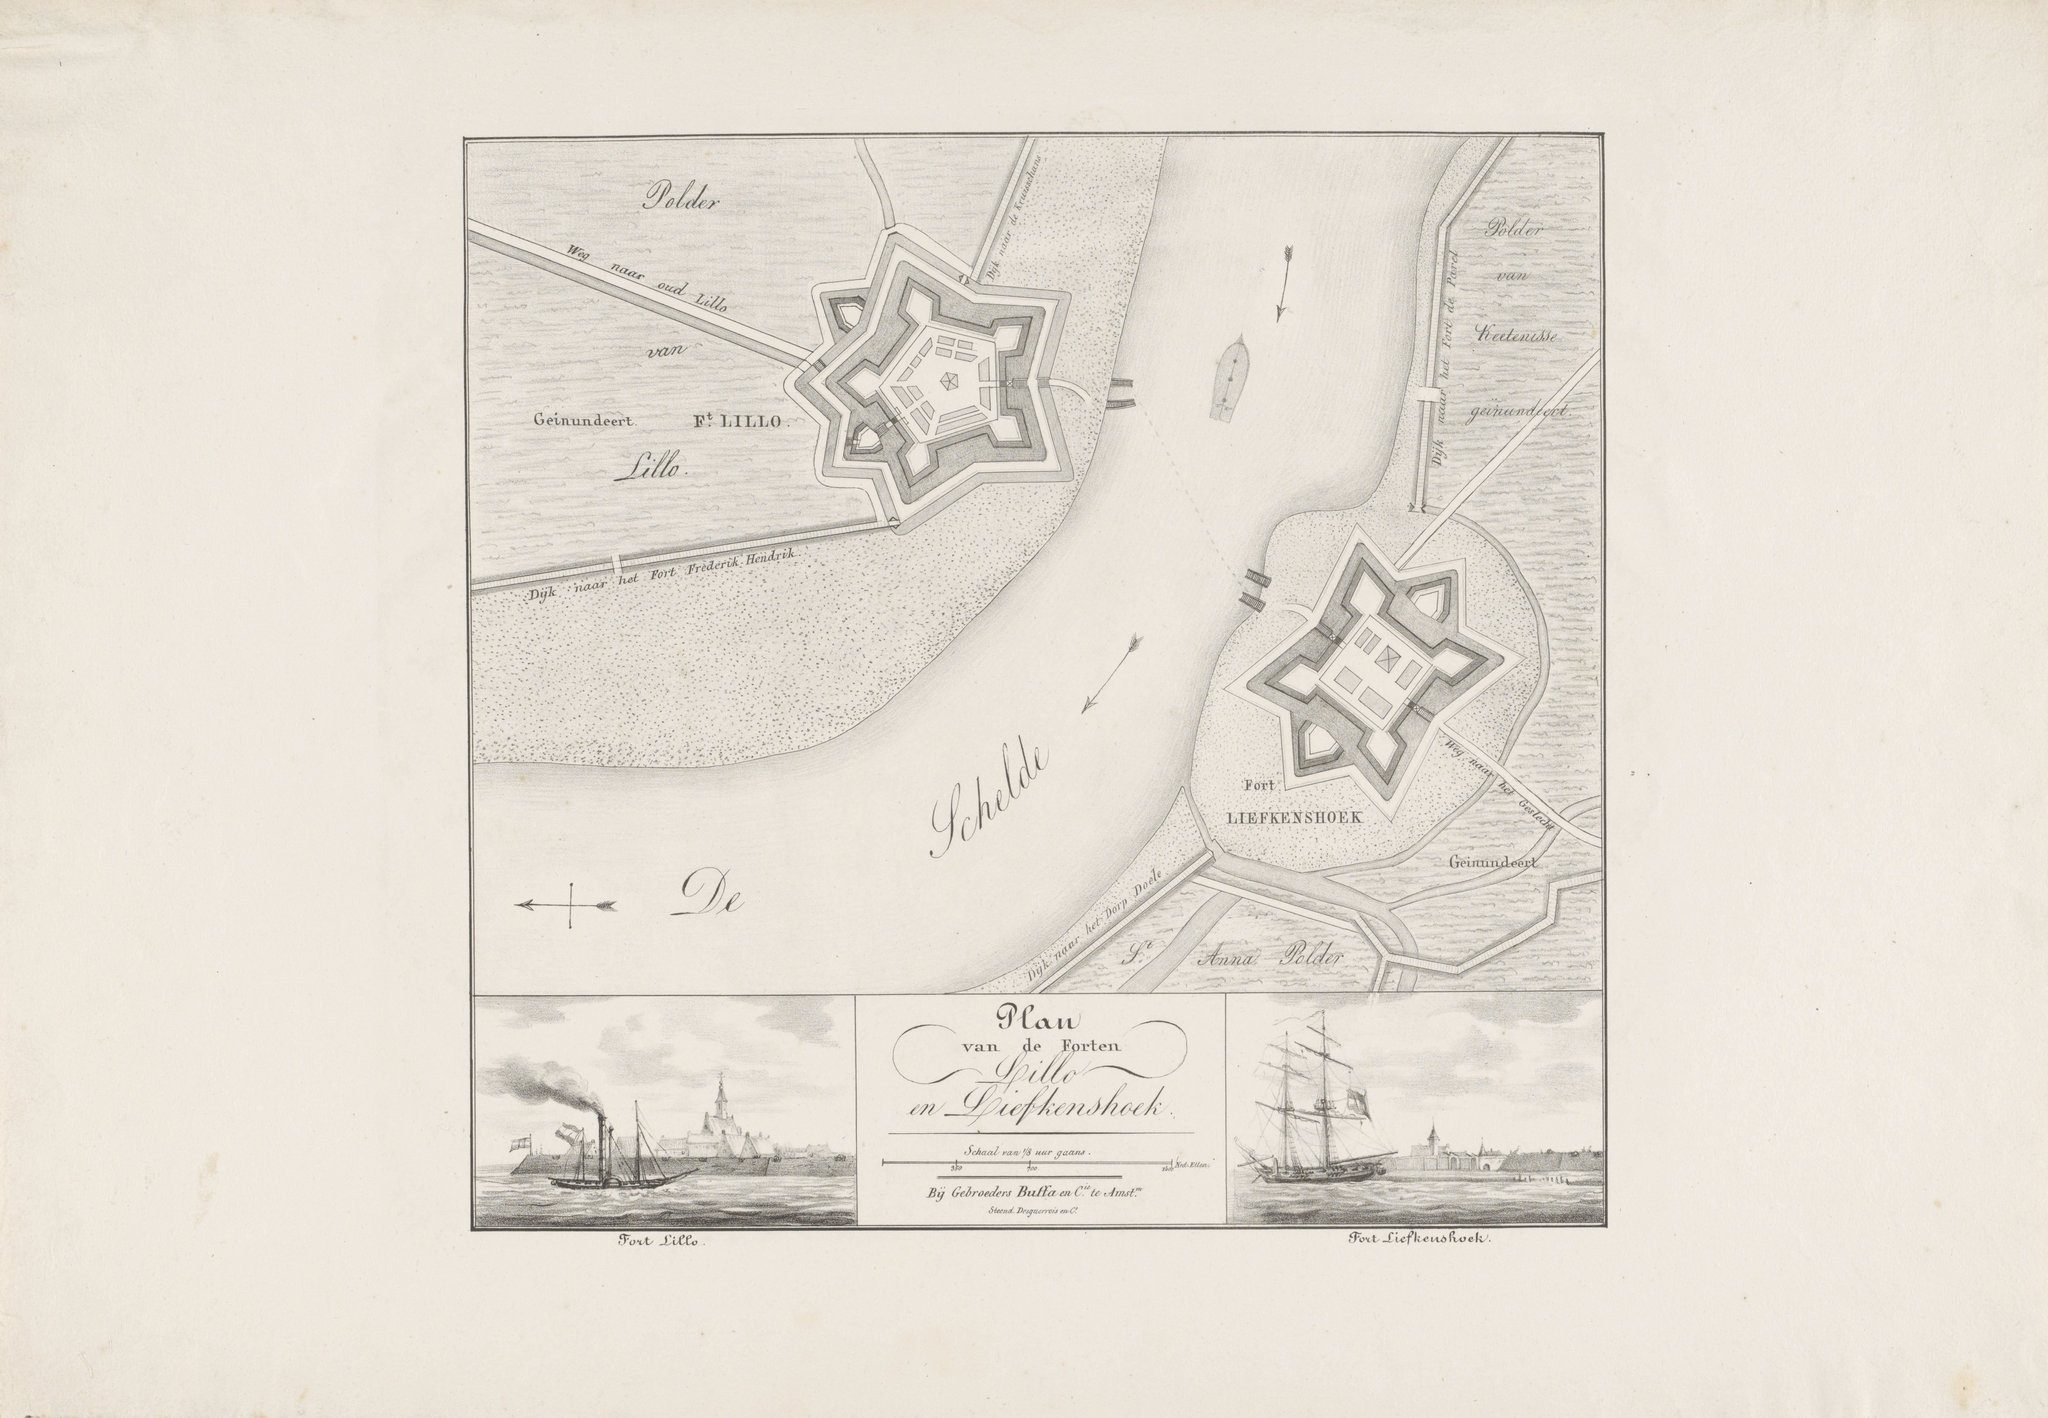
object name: map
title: Plan van de Forten Lillo en Liefkenshoek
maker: Anonymous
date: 1832-1833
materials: paper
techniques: lithograph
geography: amsterdam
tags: fortress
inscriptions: collector's mark: Lugt 2228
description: Plan van de forten Lillo en Liefkenshoek, gelegen tegenover elkaar aan weerszijden van de Schelde. Onderaan twee kleine gezichten op de forten vanaf het water, met schepen. In verband met het beleg van de Citadel van Antwerpen door het Franse leger, december 1832.